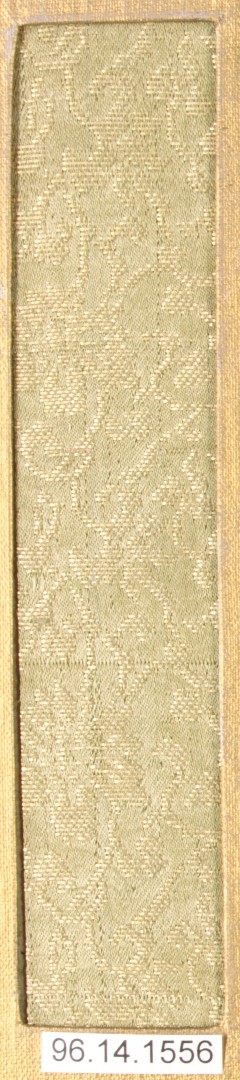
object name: piece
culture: japanese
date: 1701-1900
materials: silk